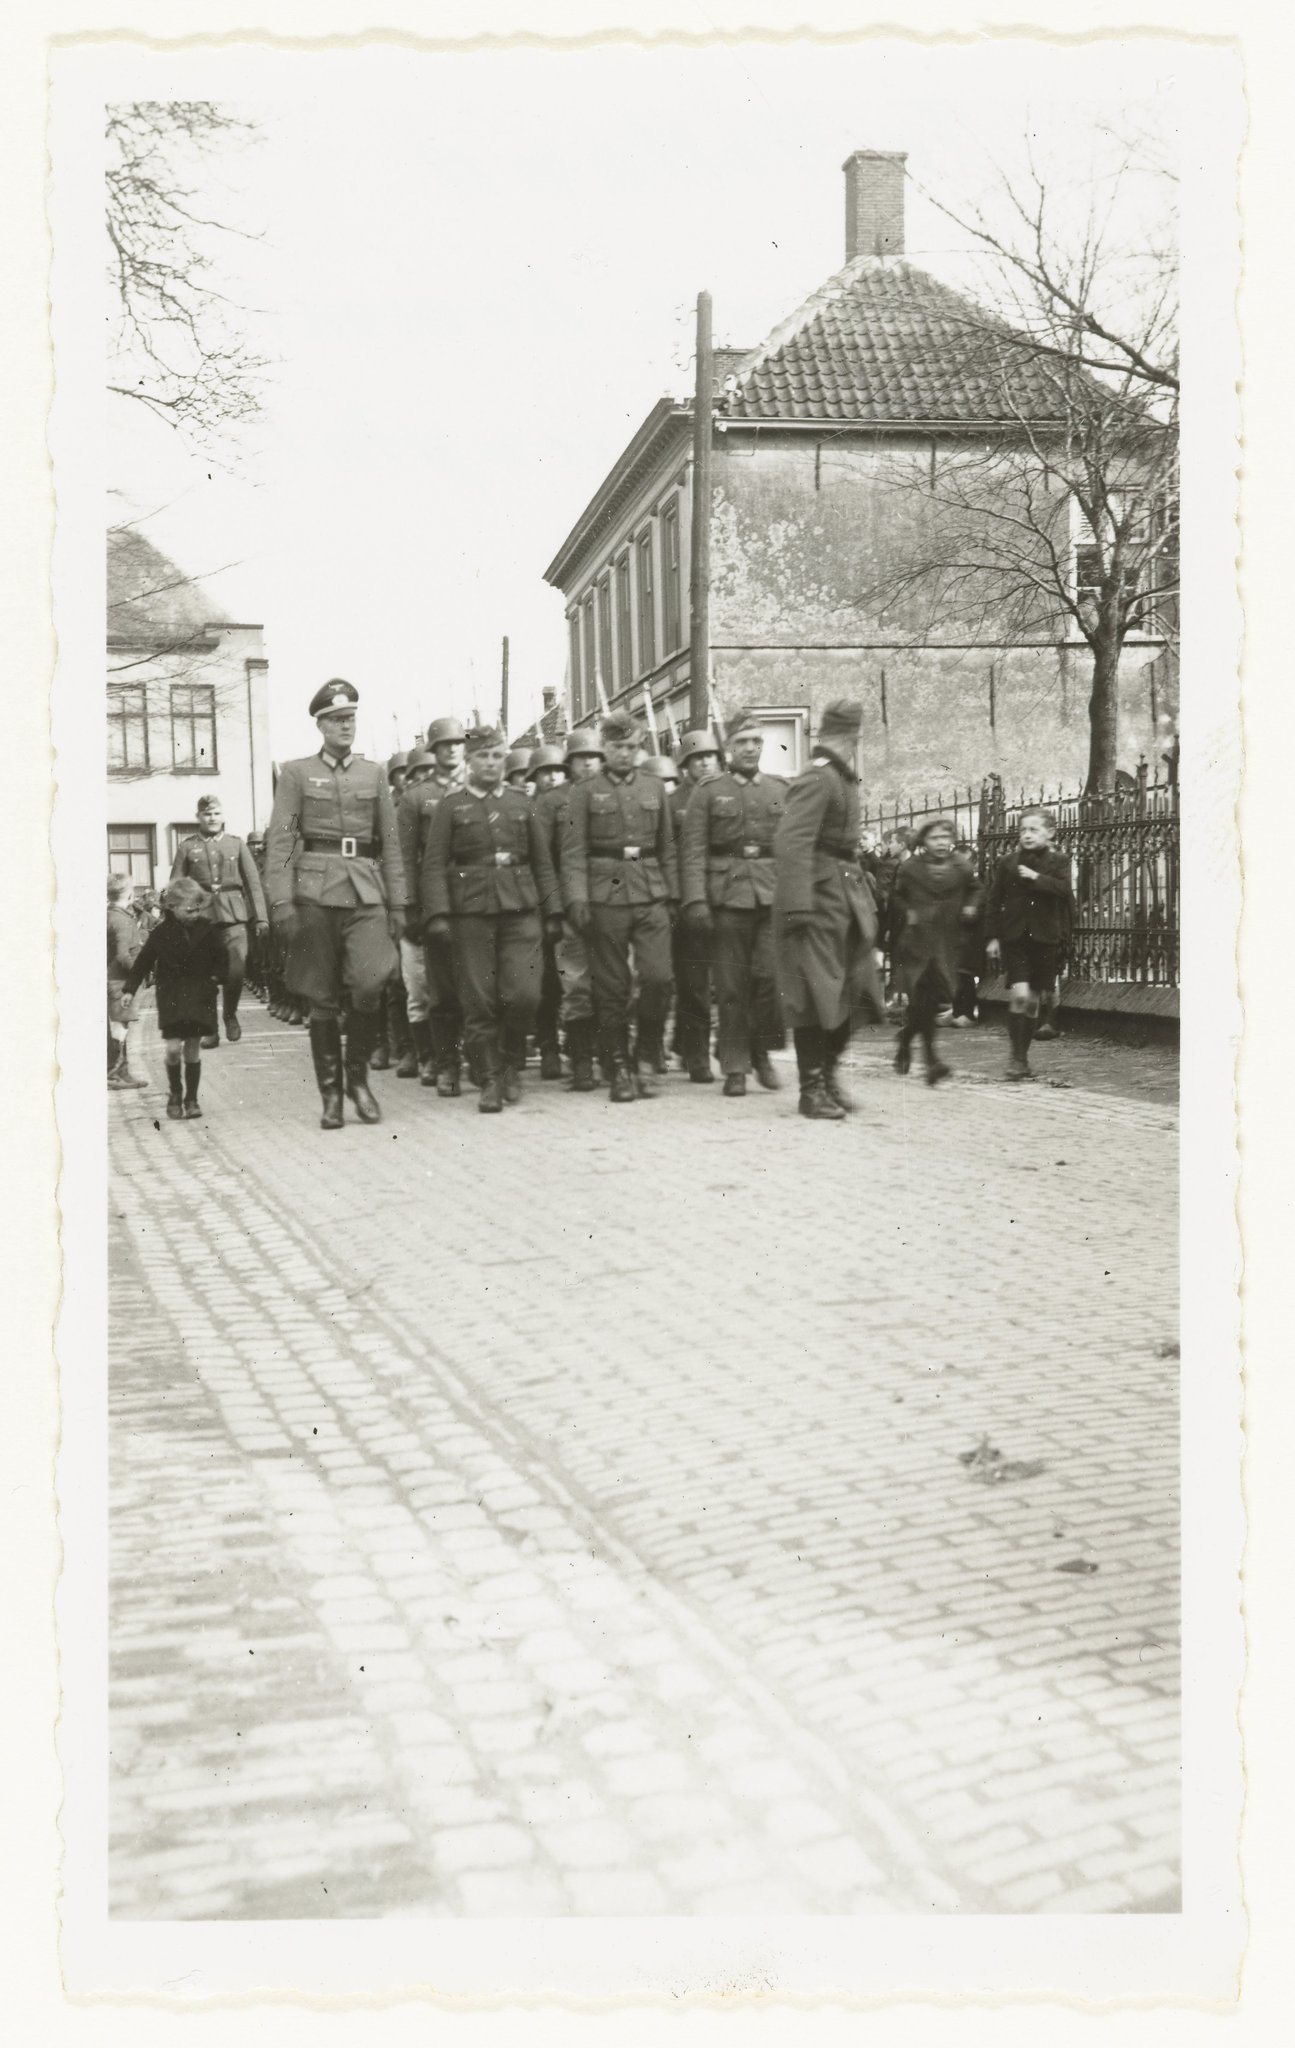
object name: photograph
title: Wehrmacht militairen lopen in een straat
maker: Anonymous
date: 1941-1942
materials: photographic support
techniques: gelatin silver print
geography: raamsdonksveer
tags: drill ~ military training, occupation ~ war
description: Een compagnie Duitse militairen lopen in een straat. Links en rechts lopen kinderen mee. Achterop staat: In Holland. Die Komp. kommt von Exerzierplatz zurück.